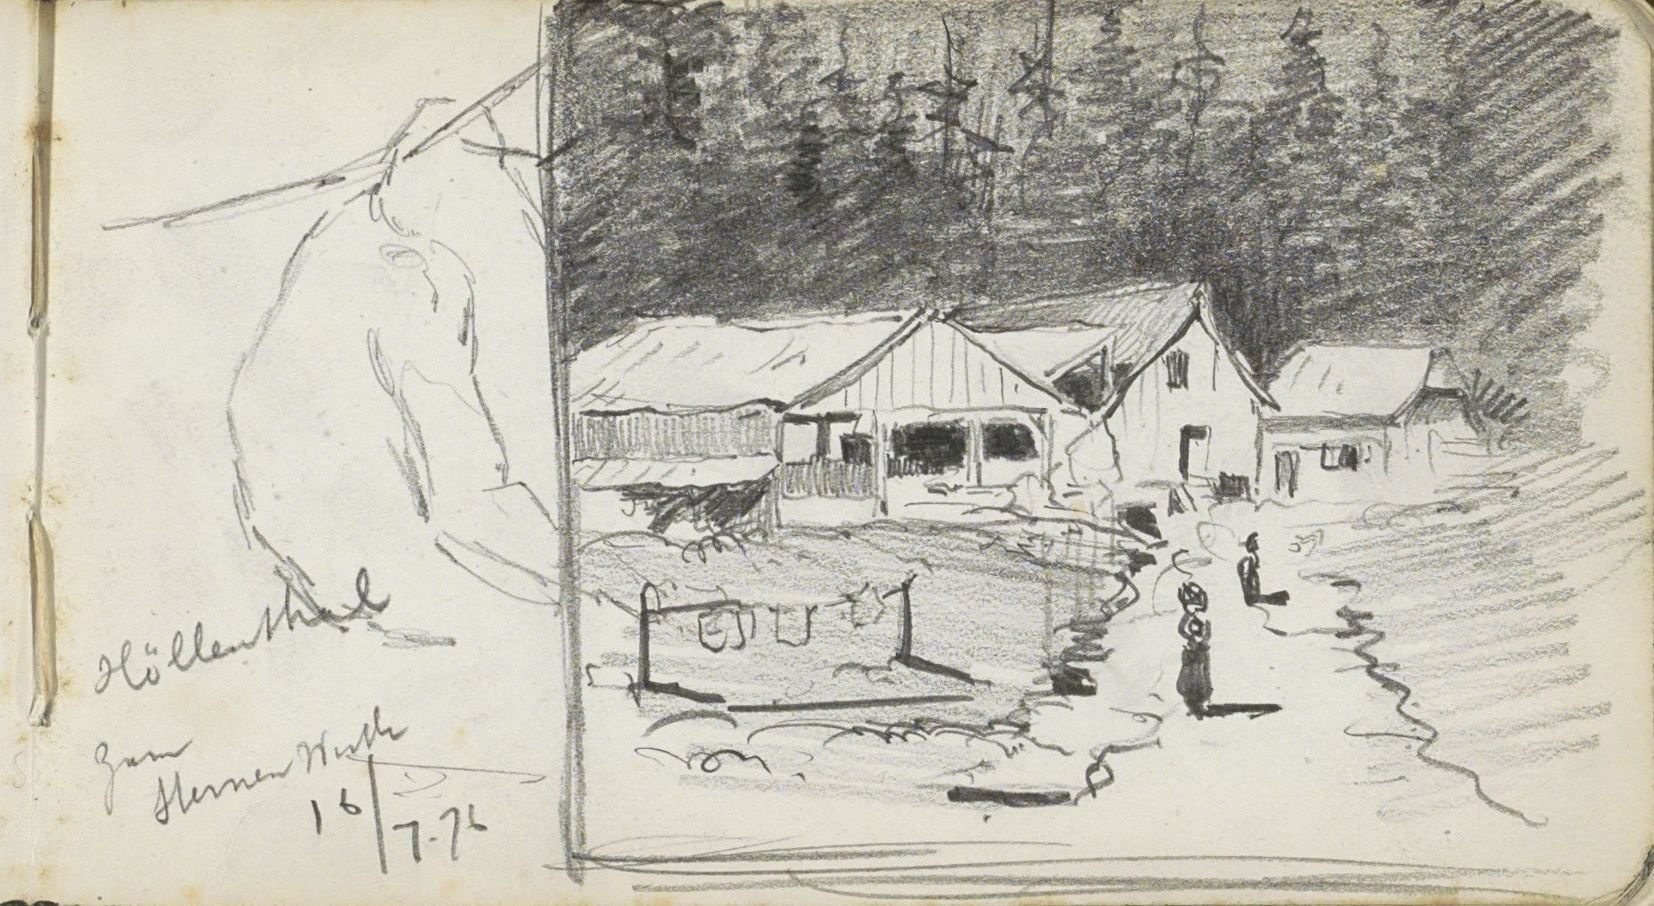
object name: sketchbook leaf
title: Huizen aan een bosrand bij het Höllental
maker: geo poggenbeek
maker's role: draughtsman, painter, print maker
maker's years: 1853-1903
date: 1807-1876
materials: paper, pencil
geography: höllental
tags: rural housing, e.g. country-house, villa, cottage, fringe, edge of the wood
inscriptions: date and inscription: ‘Höllenthal zum Her[...]enwurth/ 16/7 76’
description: Naast de huizen twee figuren op een pad en een waslijn waar was aan hangt te drogen. Blad 46 recto uit een schetsboek met 69 bladen.